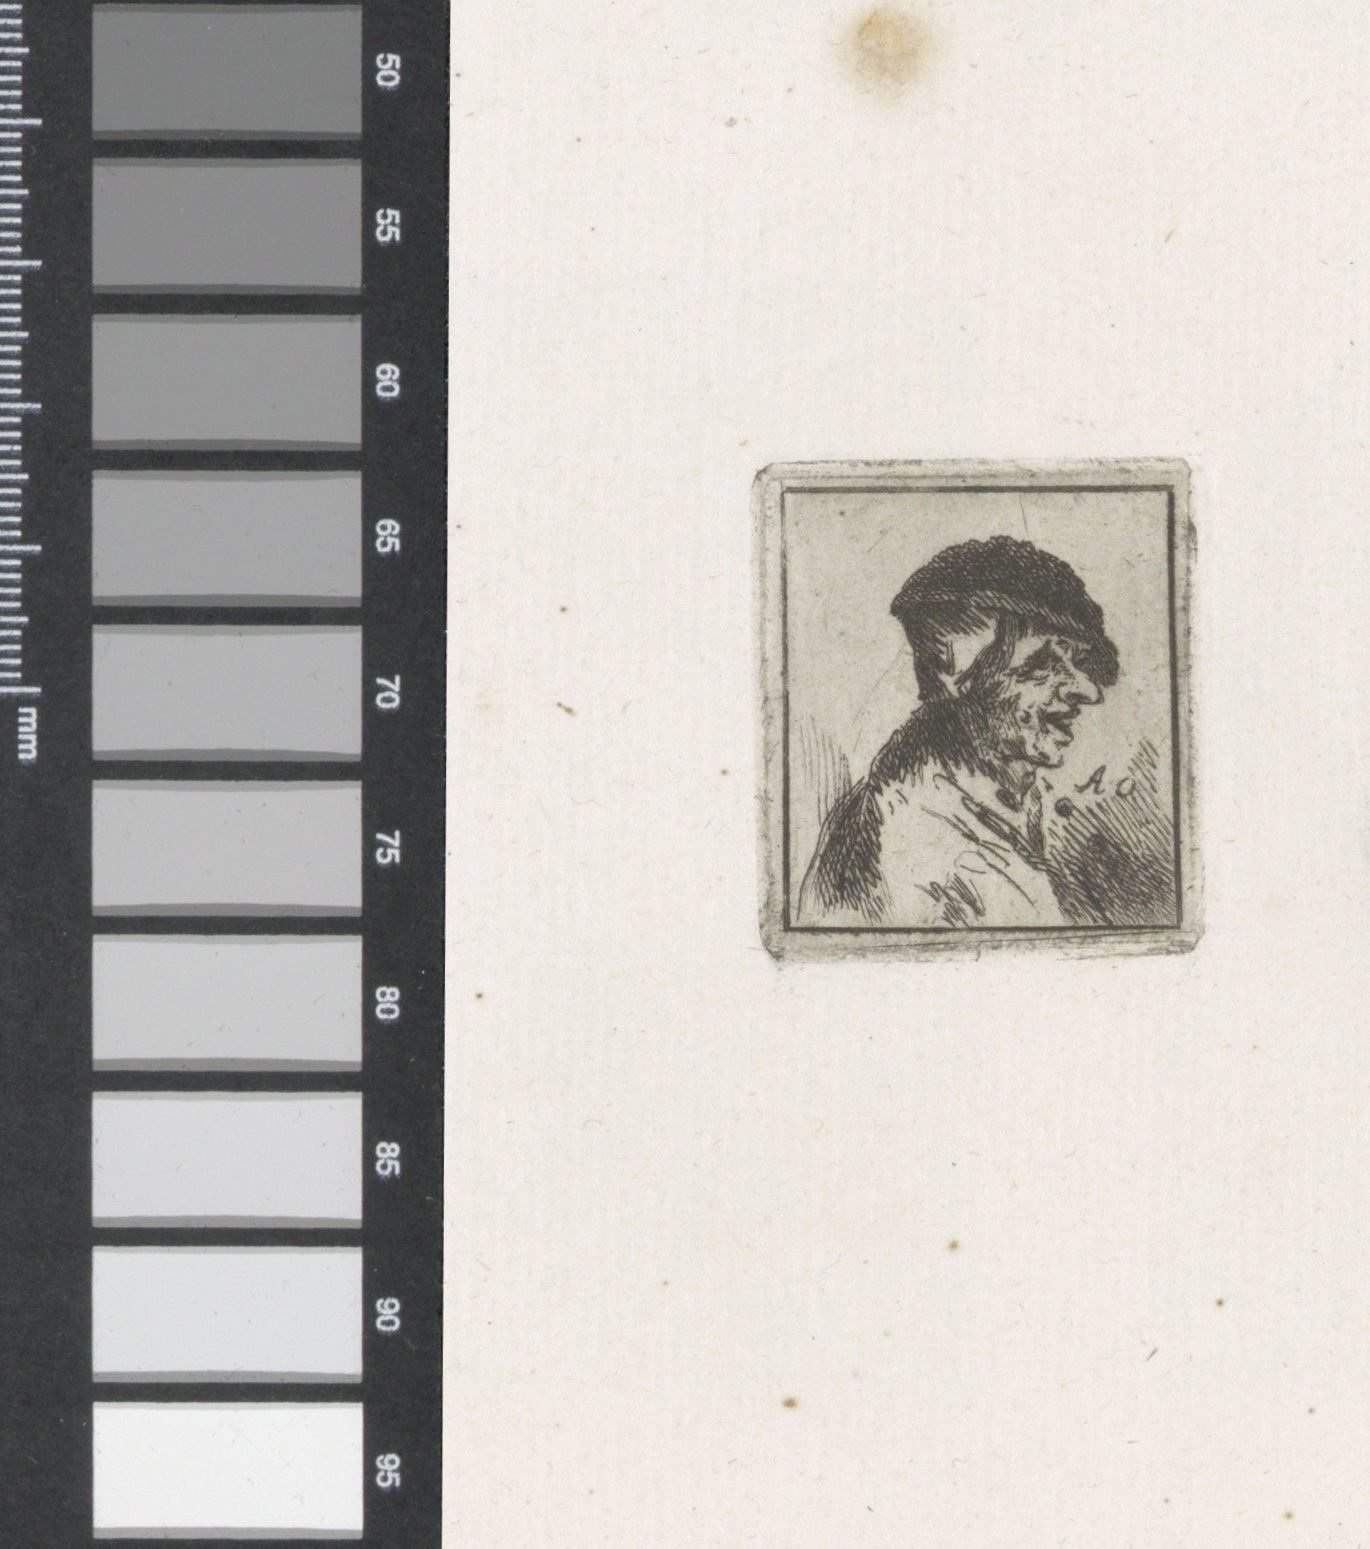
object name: album leaf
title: Buste van een lachende boer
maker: adriaen van ostade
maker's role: draughtsman, painter, print maker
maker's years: 1610-1685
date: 1650-1652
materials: paper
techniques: etching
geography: haarlem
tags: head (human) (+ sideview, profile), laughing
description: Deze prent maakt deel uit van een album.